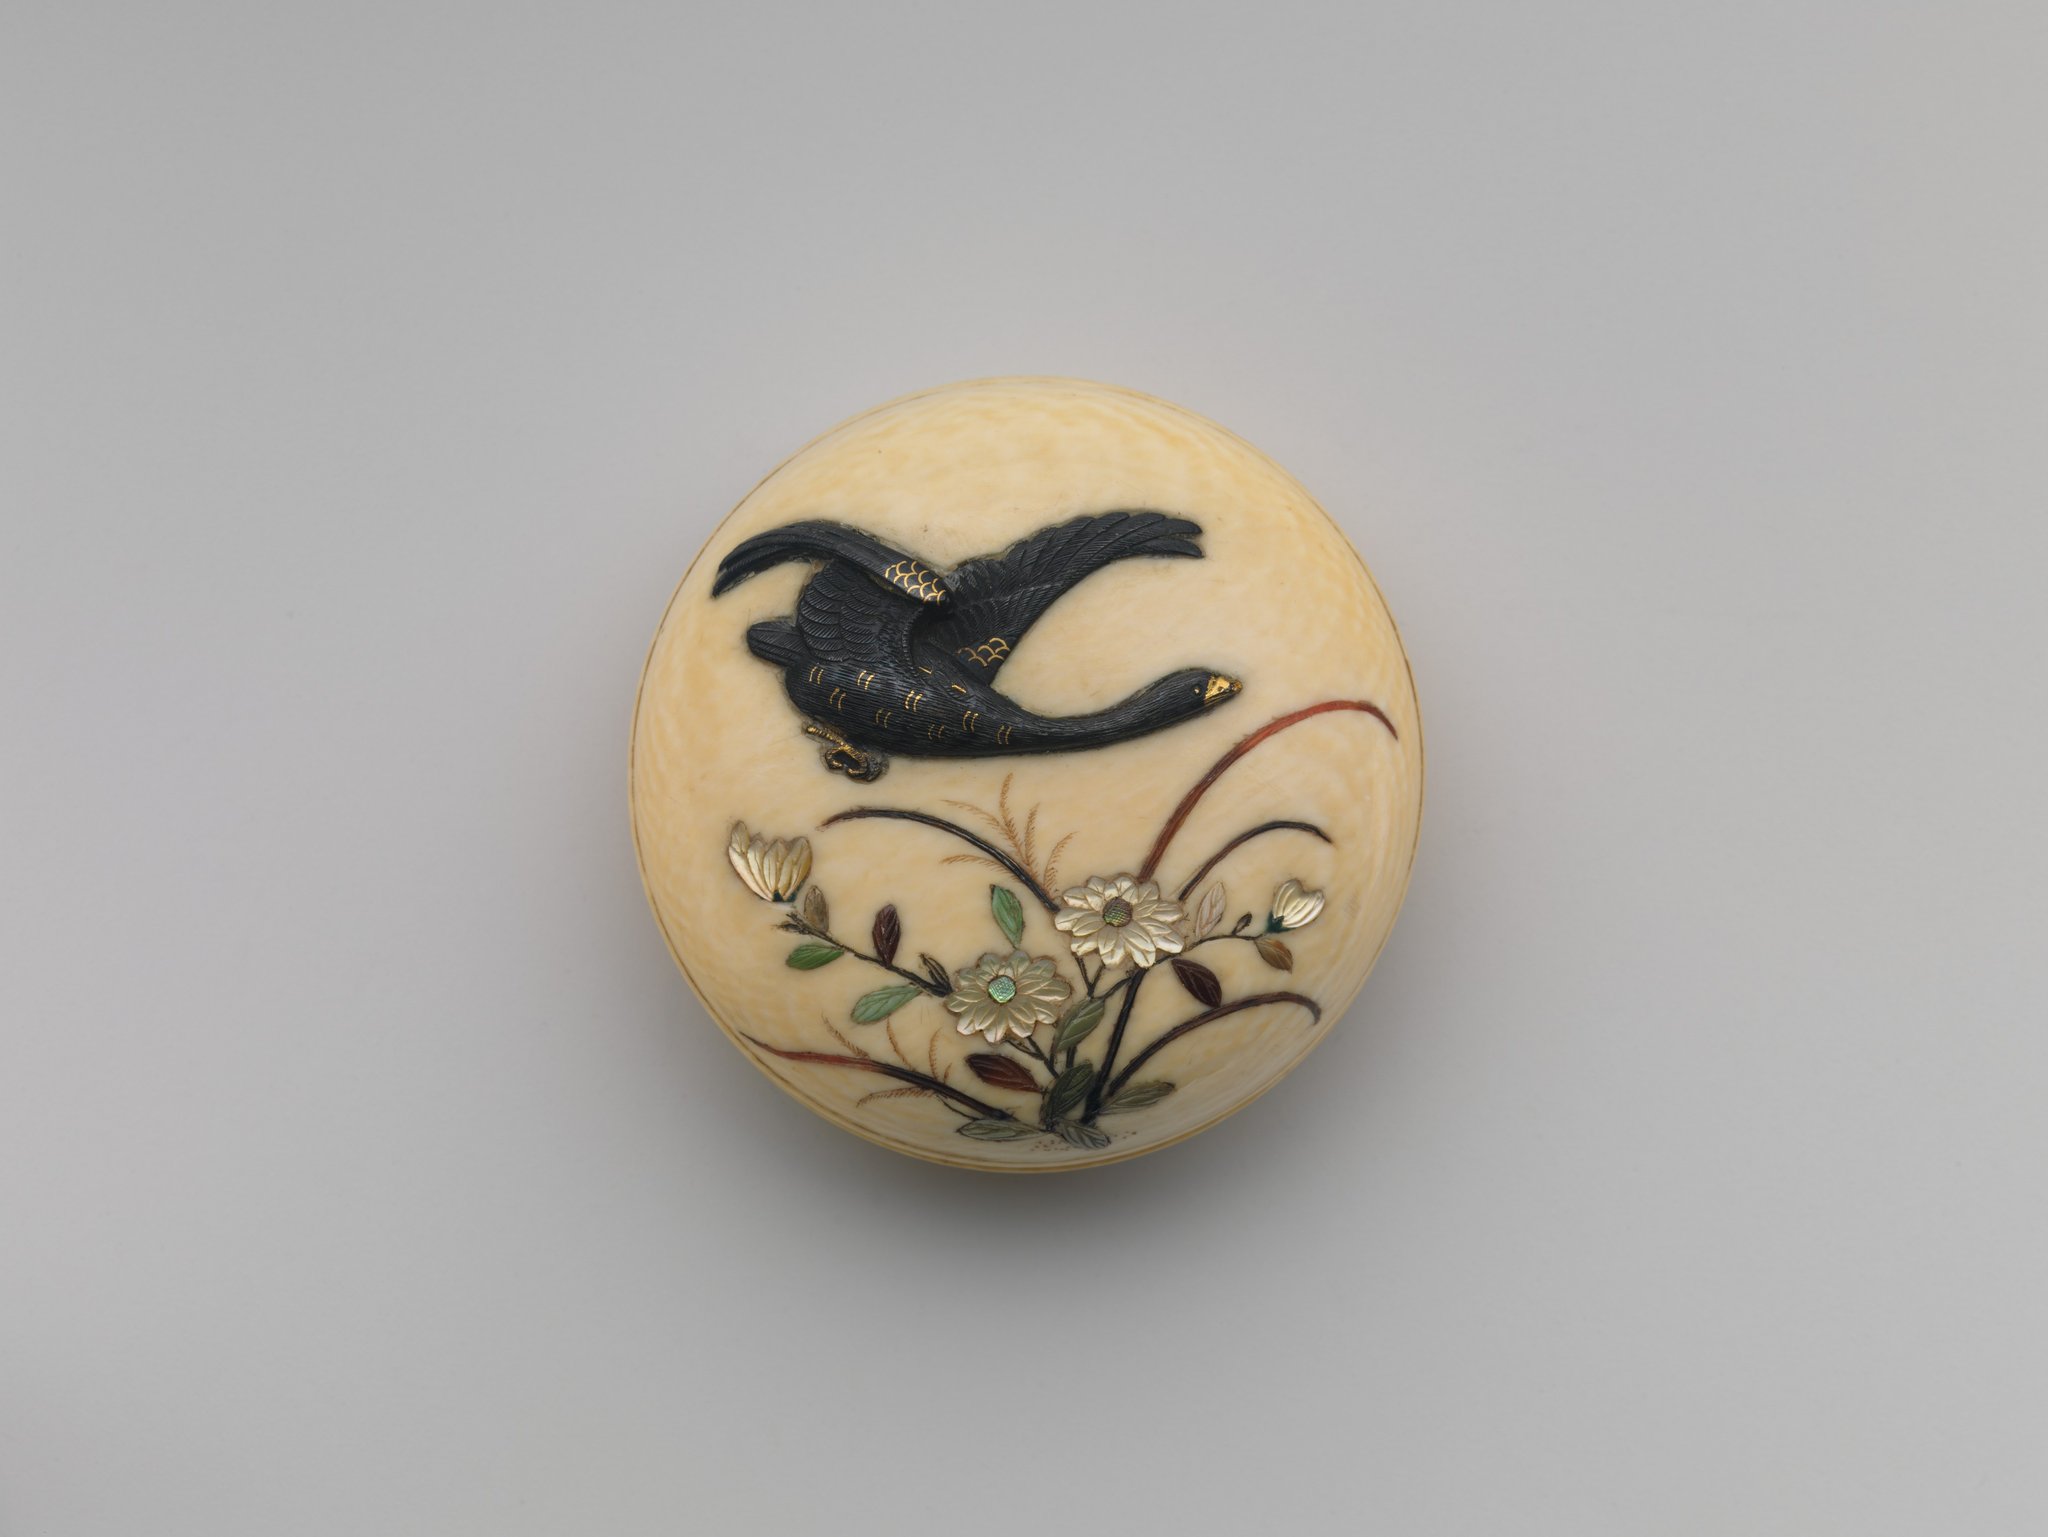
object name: netsuke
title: Netsuke of Flying Goose over Flowers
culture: japanese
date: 1801-1900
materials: ivory, mother of pearl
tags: geese